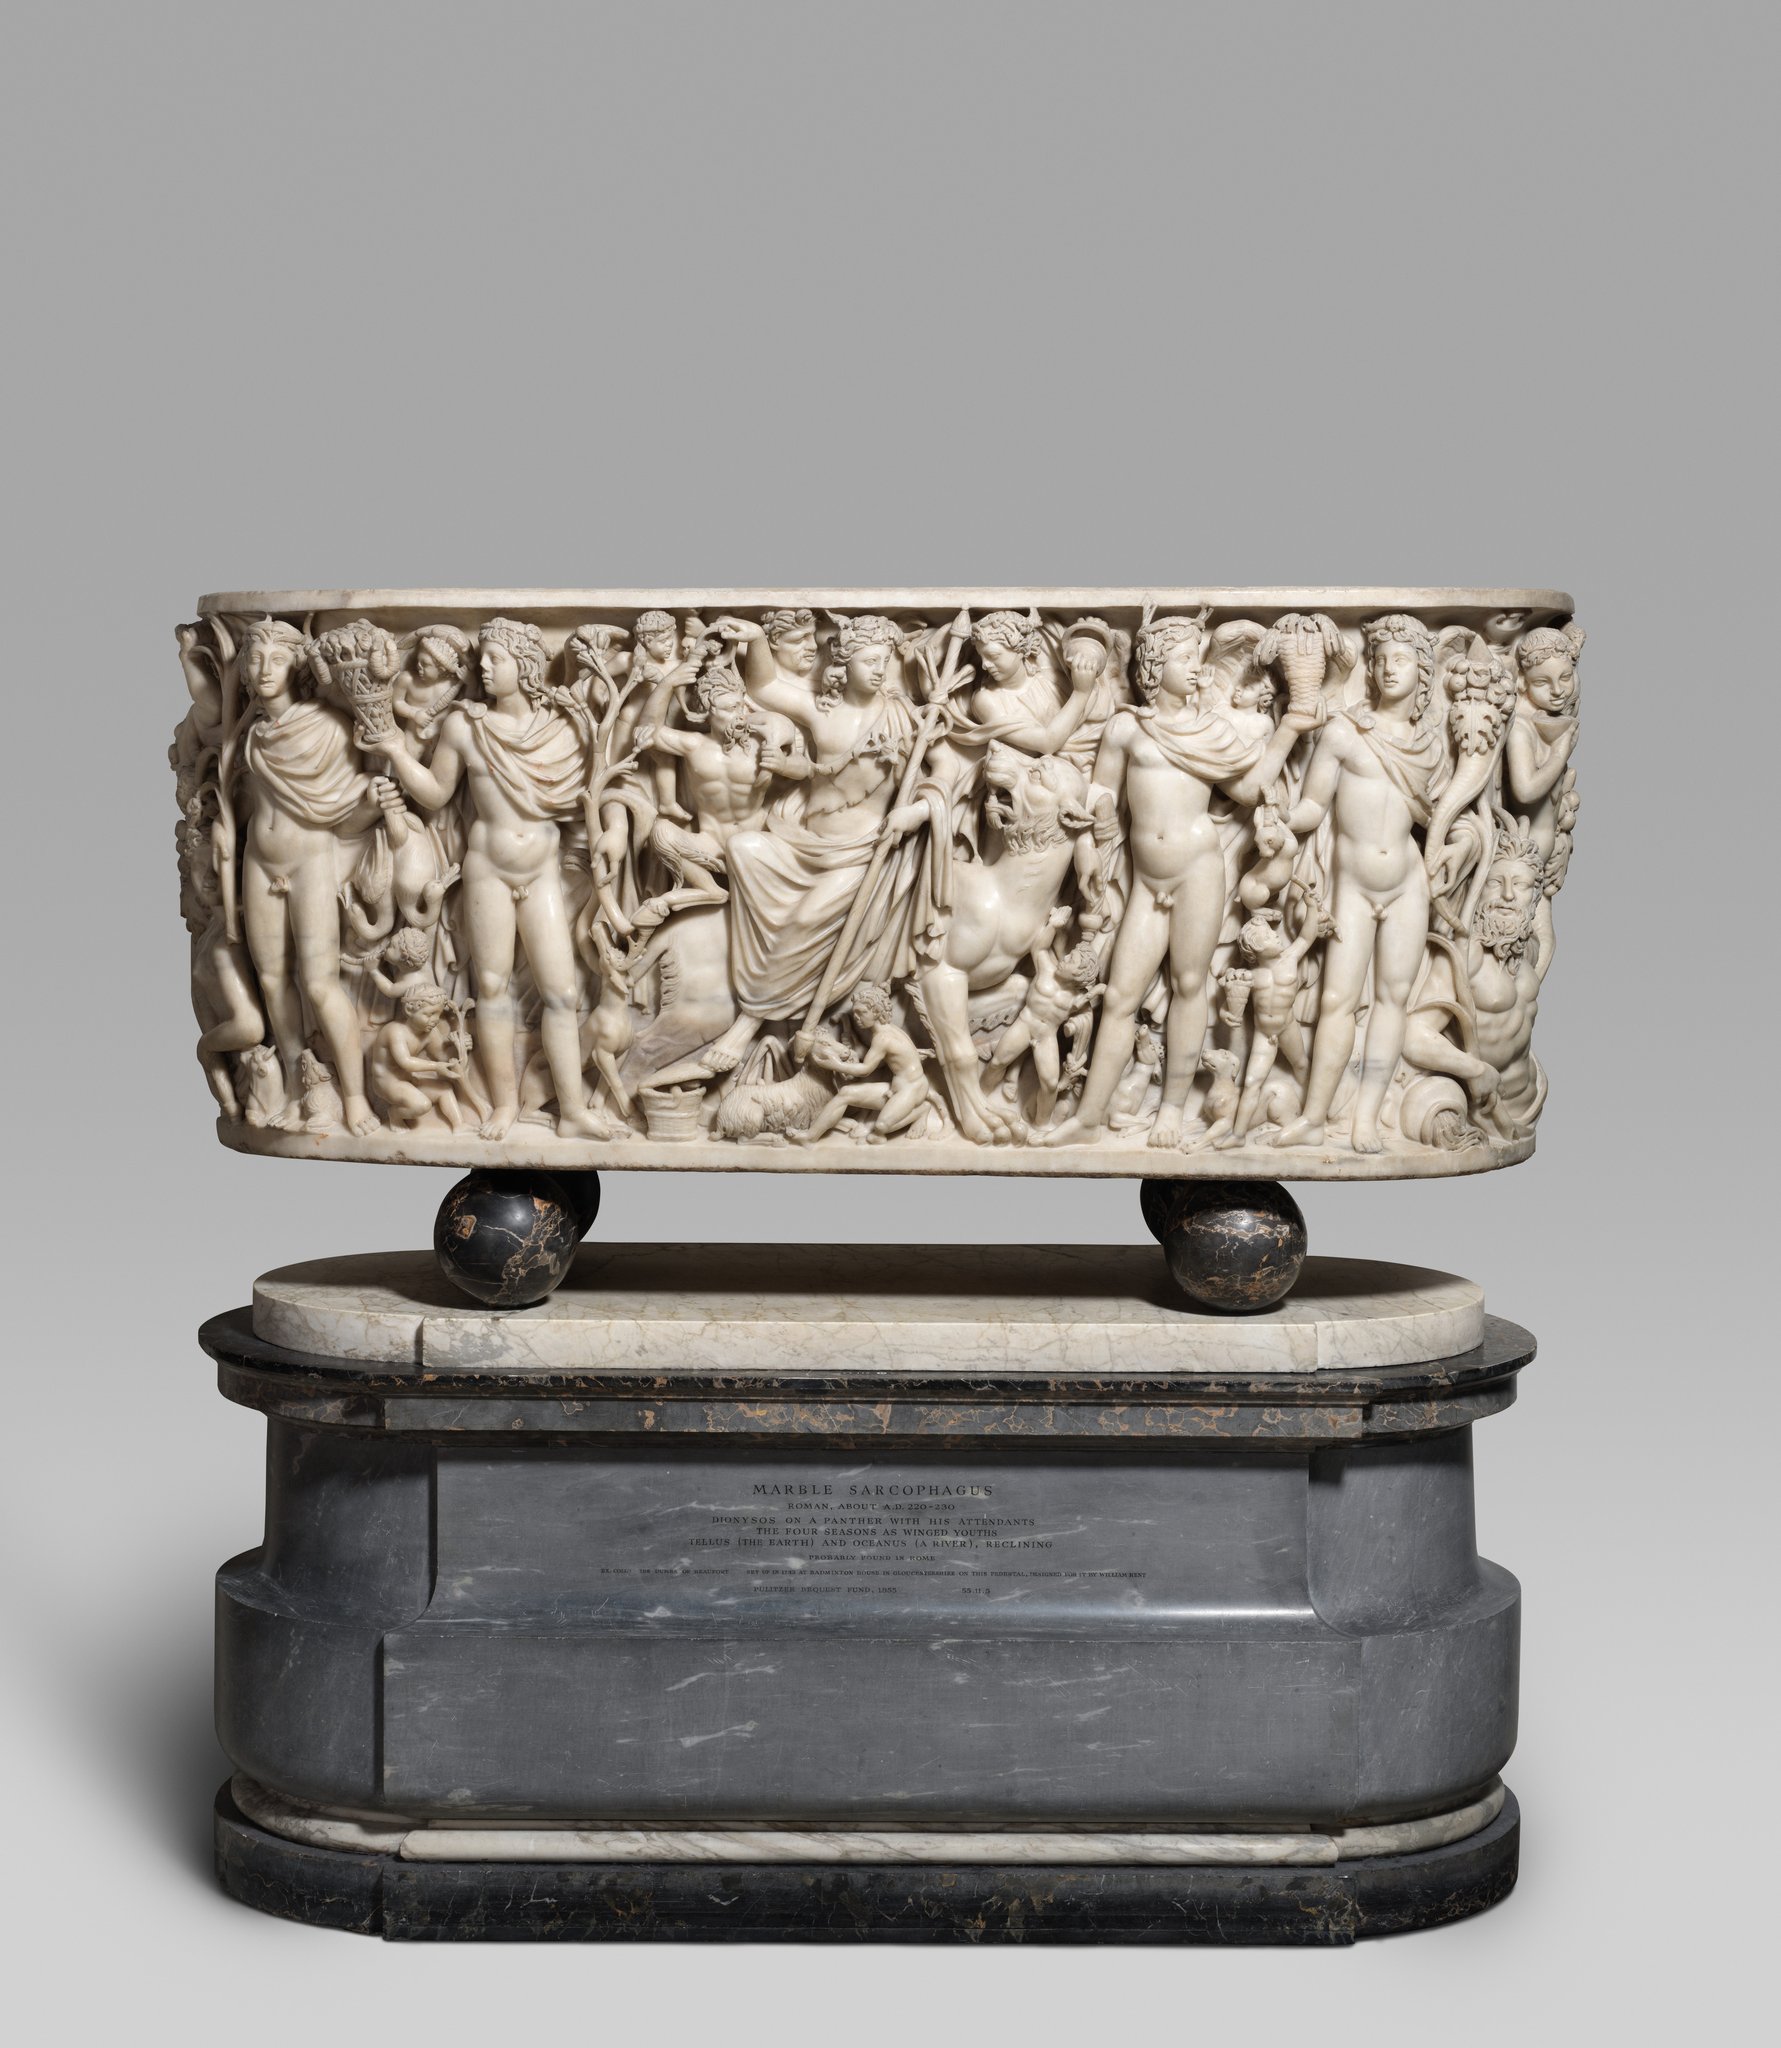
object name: sarcophagus, triumph of dionysos and the season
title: Marble sarcophagus with the Triumph of Dionysos and the Seasons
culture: roman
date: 260-270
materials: marble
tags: animals,men,male nudes,dionysus,satyrs,dogs,panthers